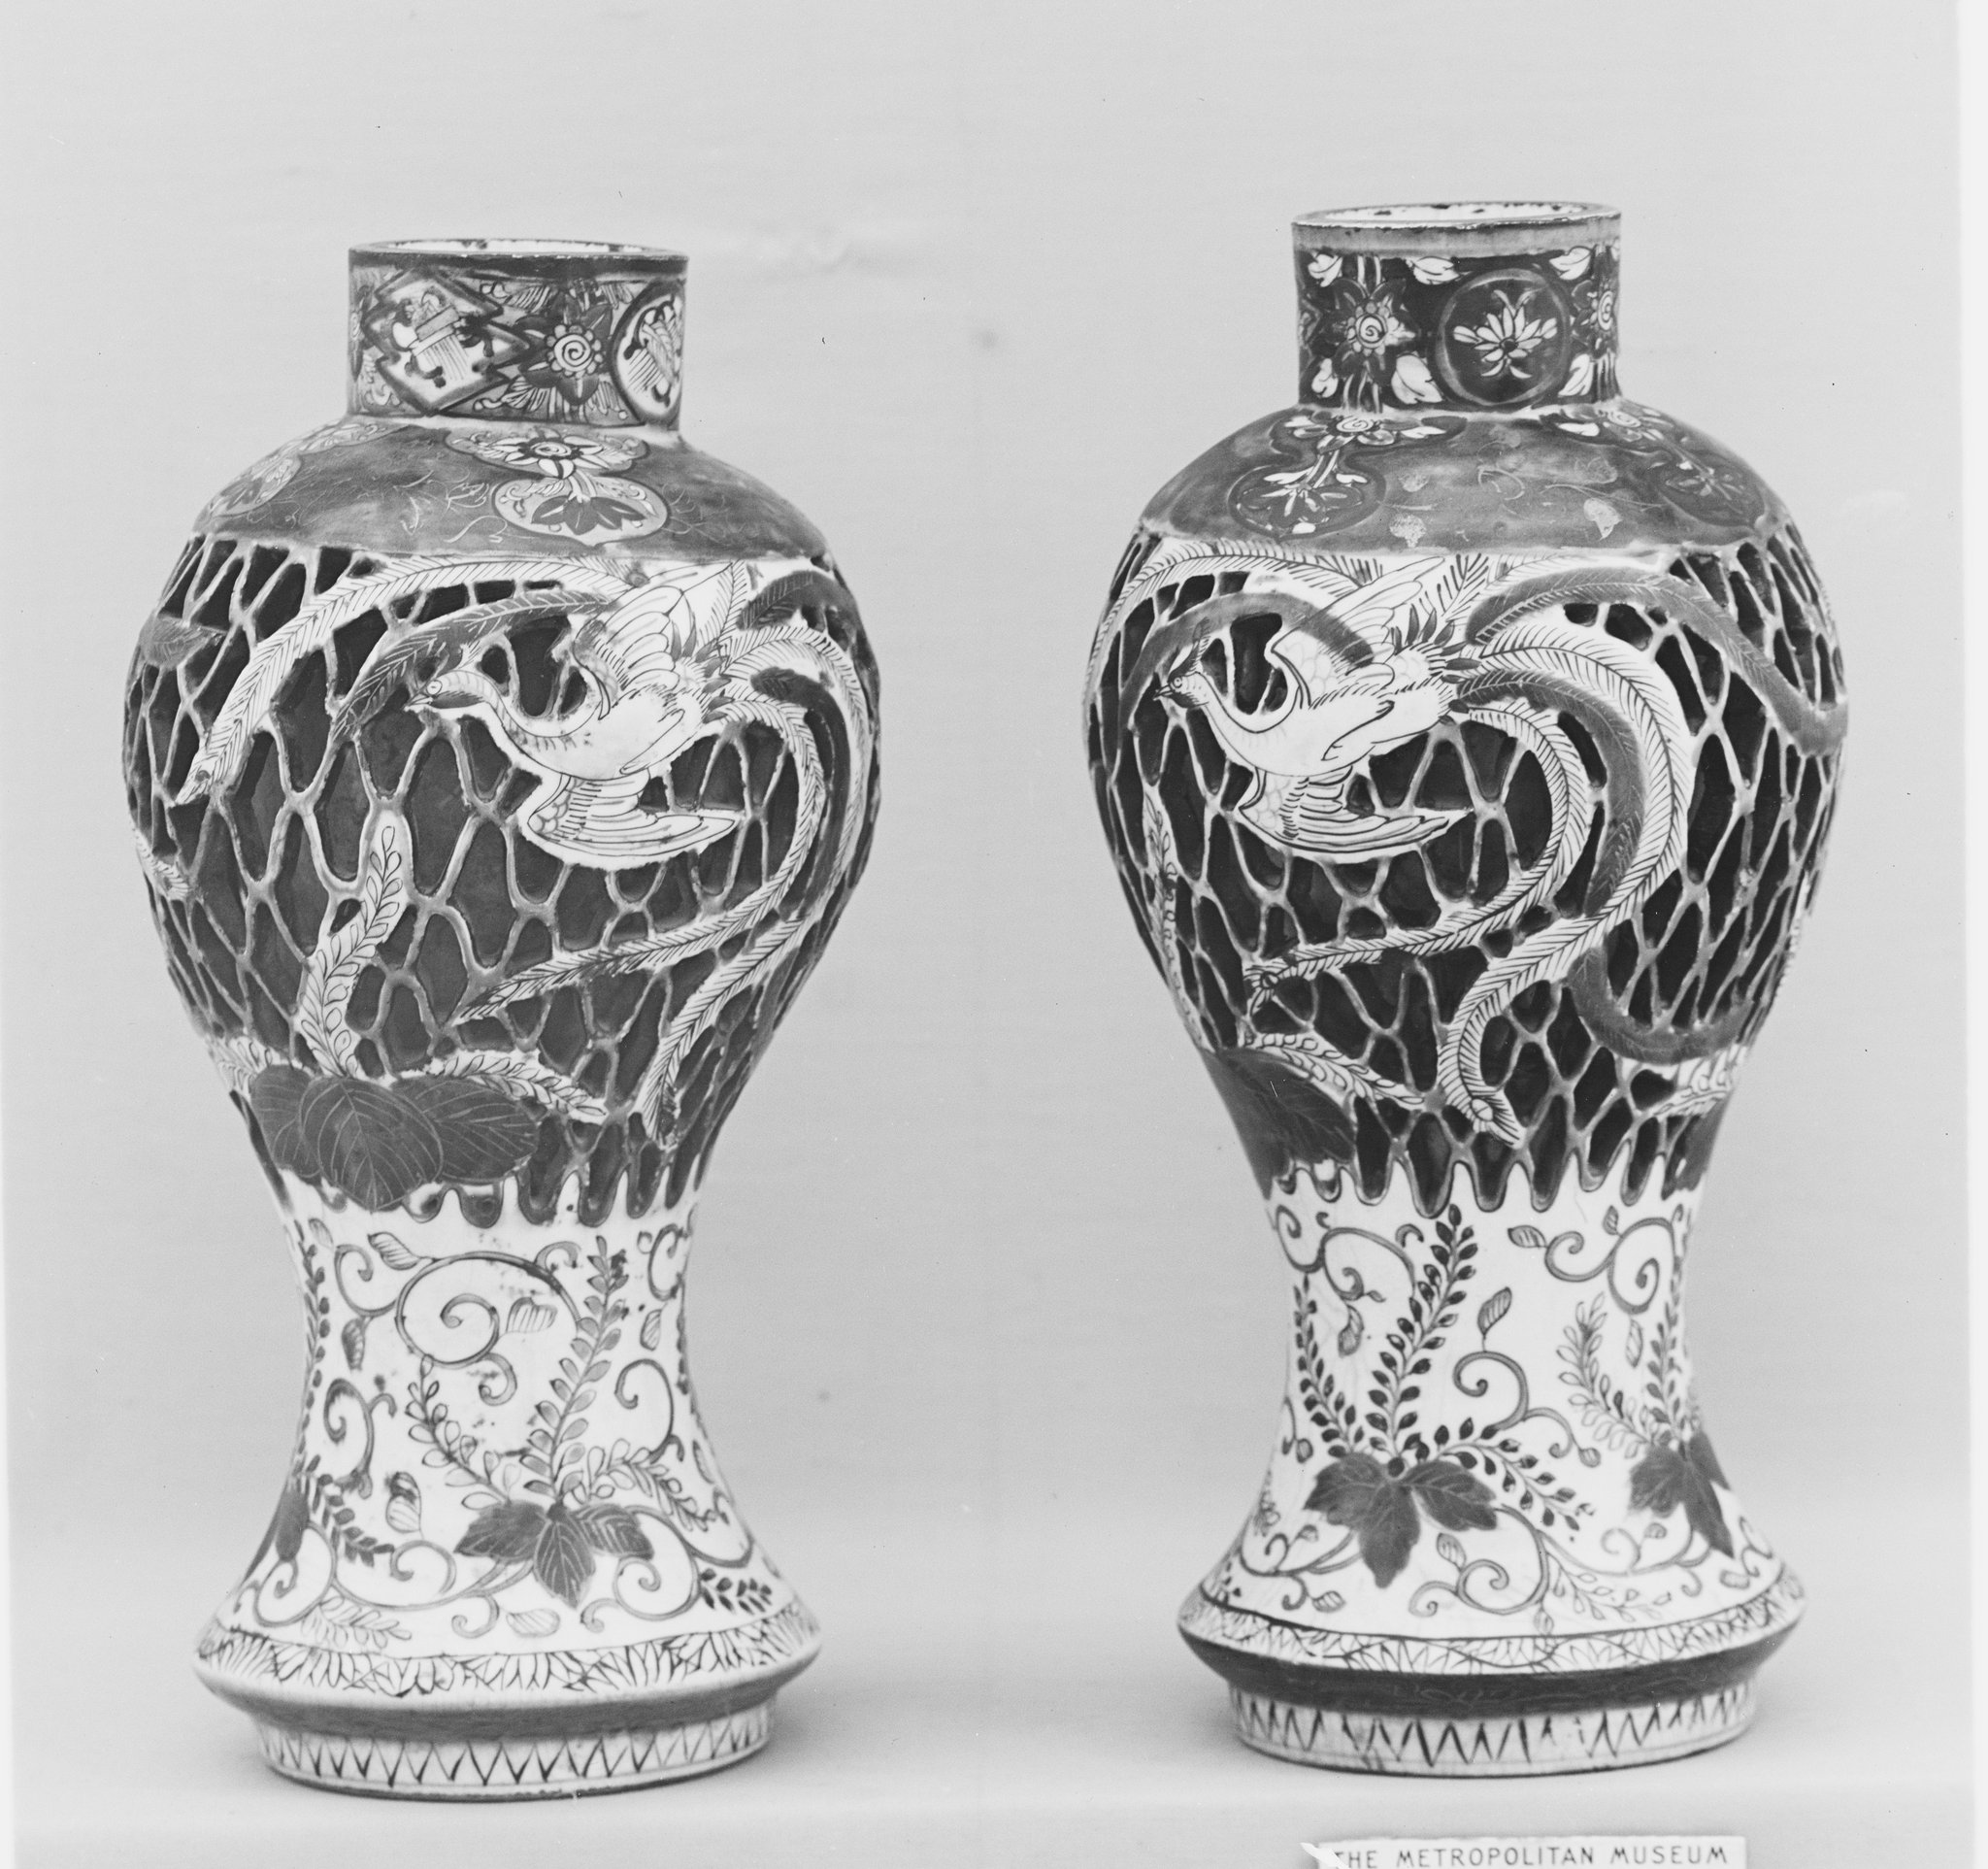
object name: vase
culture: japanese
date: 1664-1700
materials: gold, porcelain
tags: birds,leaves